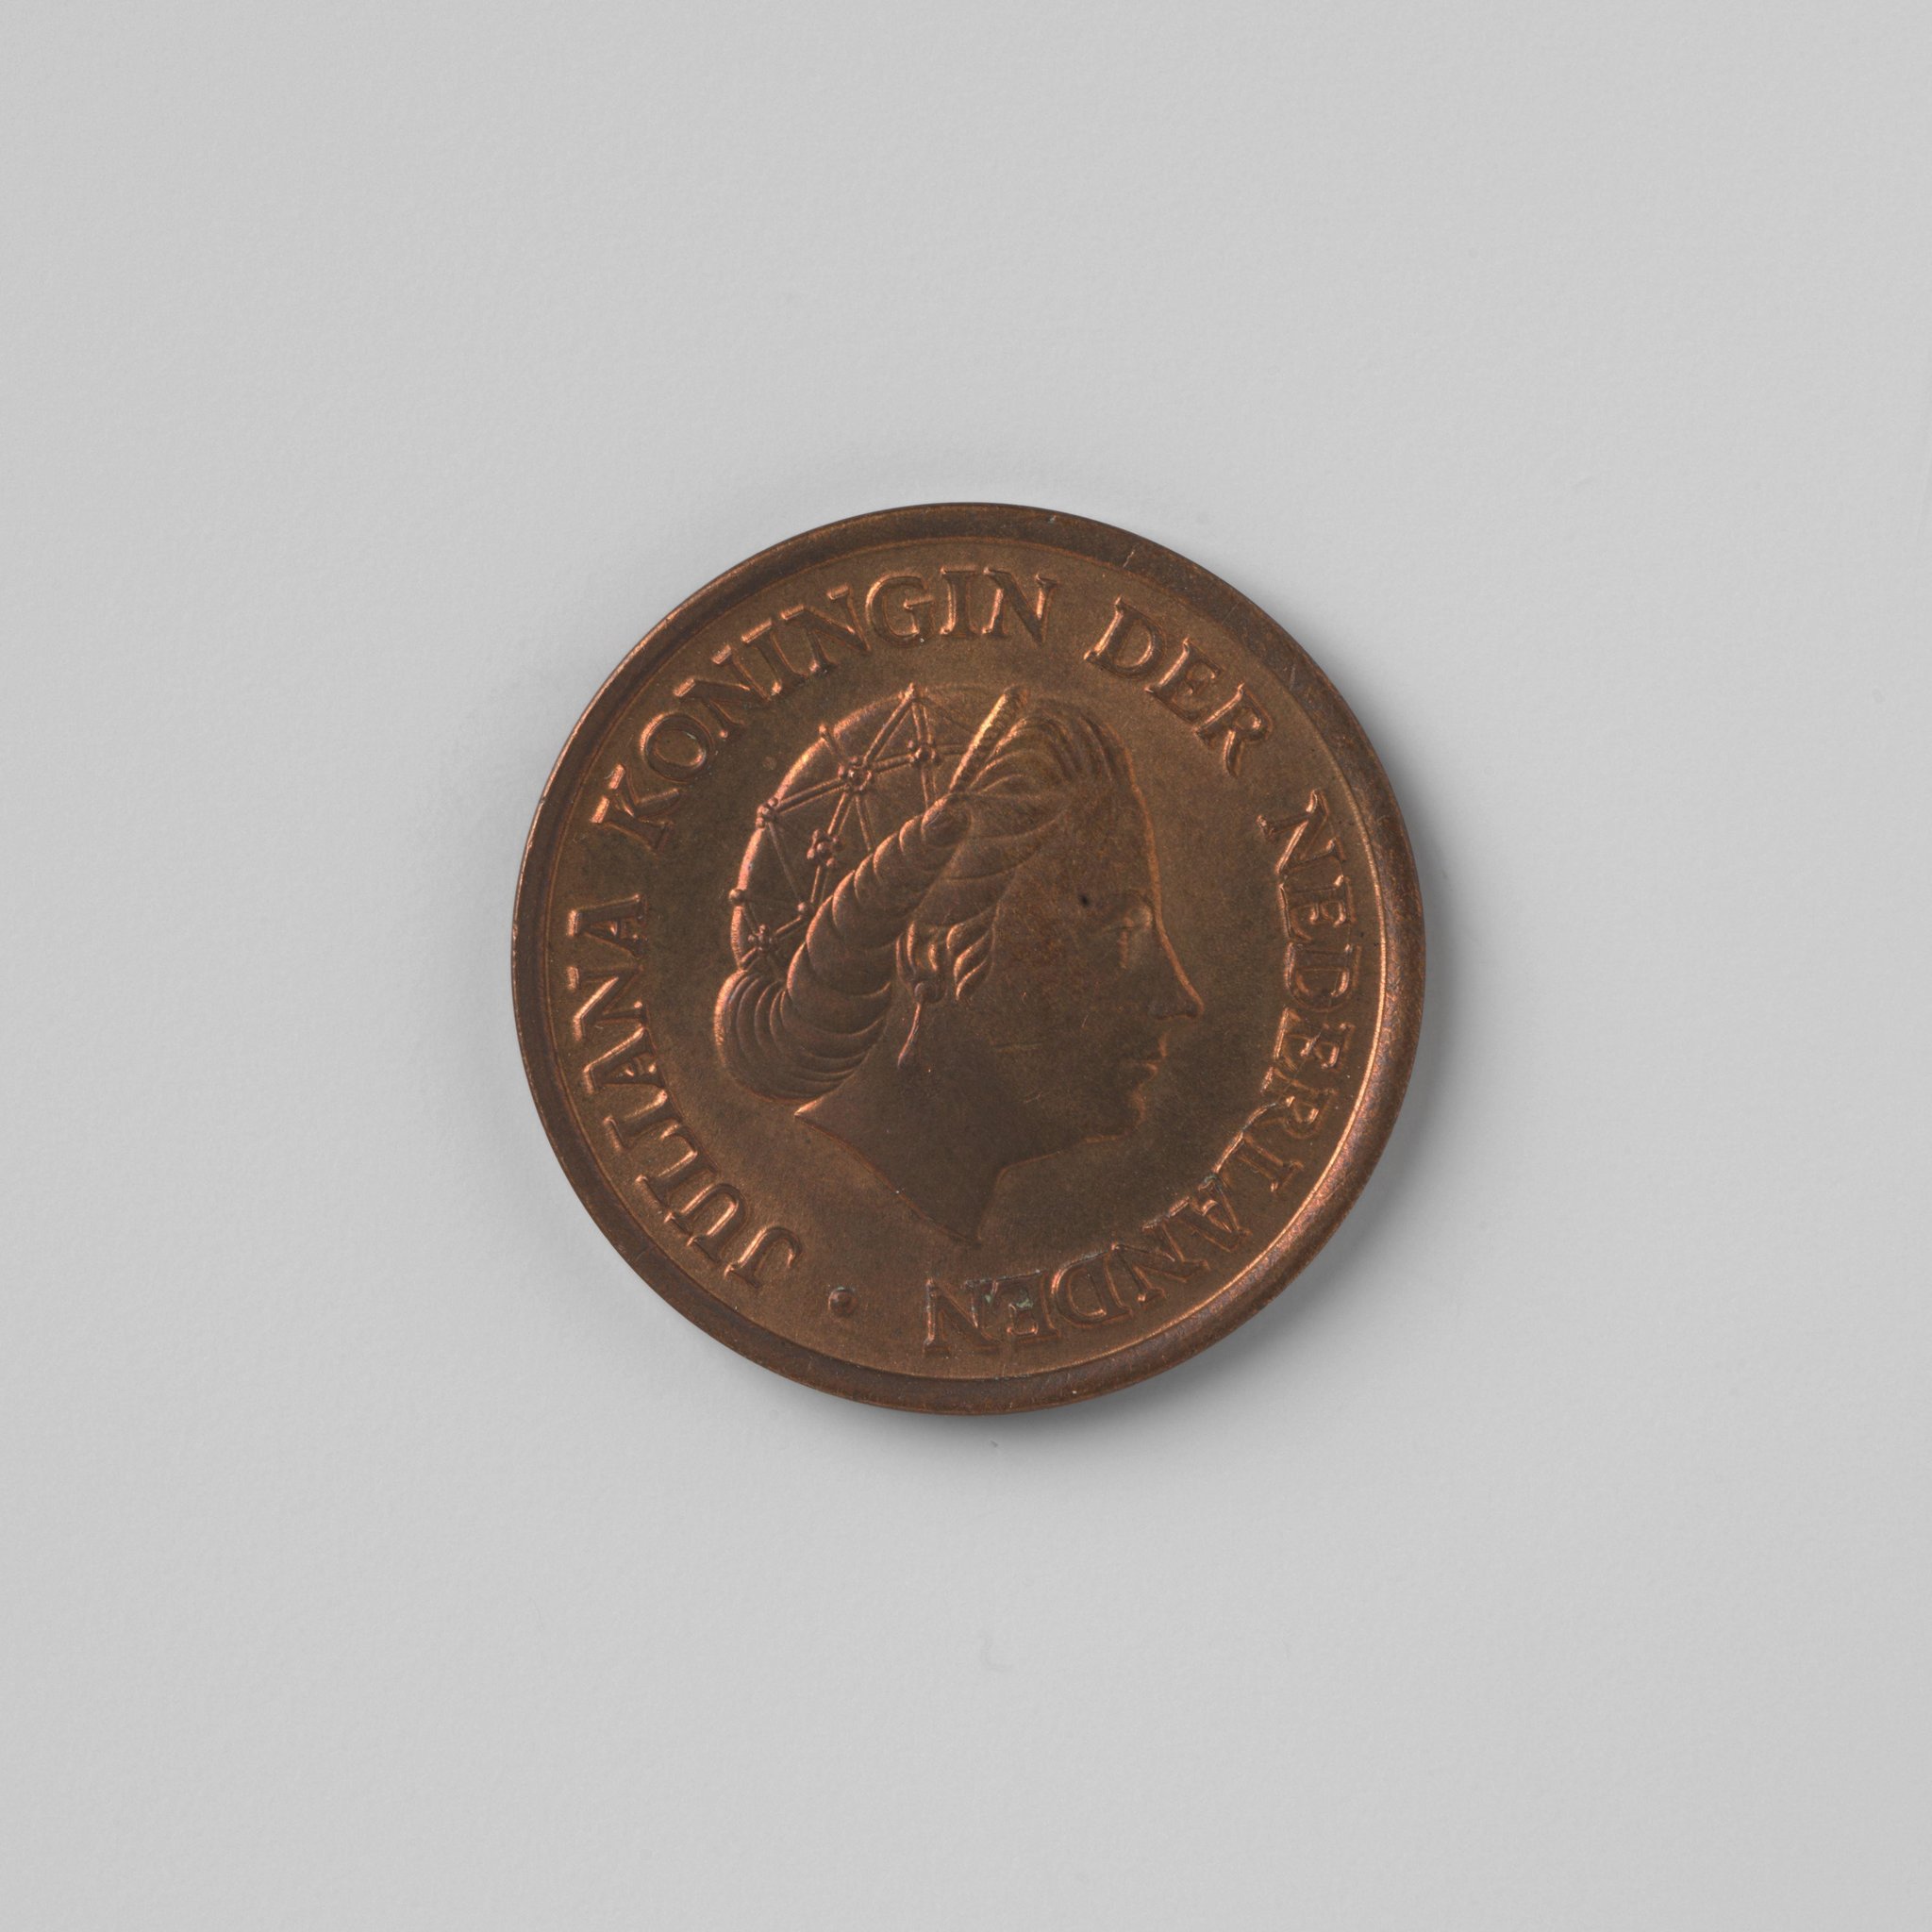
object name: coin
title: Nederland, 5 cent,1950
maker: juliana of the netherlands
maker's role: koningin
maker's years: 1909-2004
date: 1950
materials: bronze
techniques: striking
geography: utrecht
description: Bronzen munt. Voorzijde: hoofd naar rechts. Keerzijde: tussen jaartal waarde-aanduiding 5 cent met oranjetak. Gladde rand.